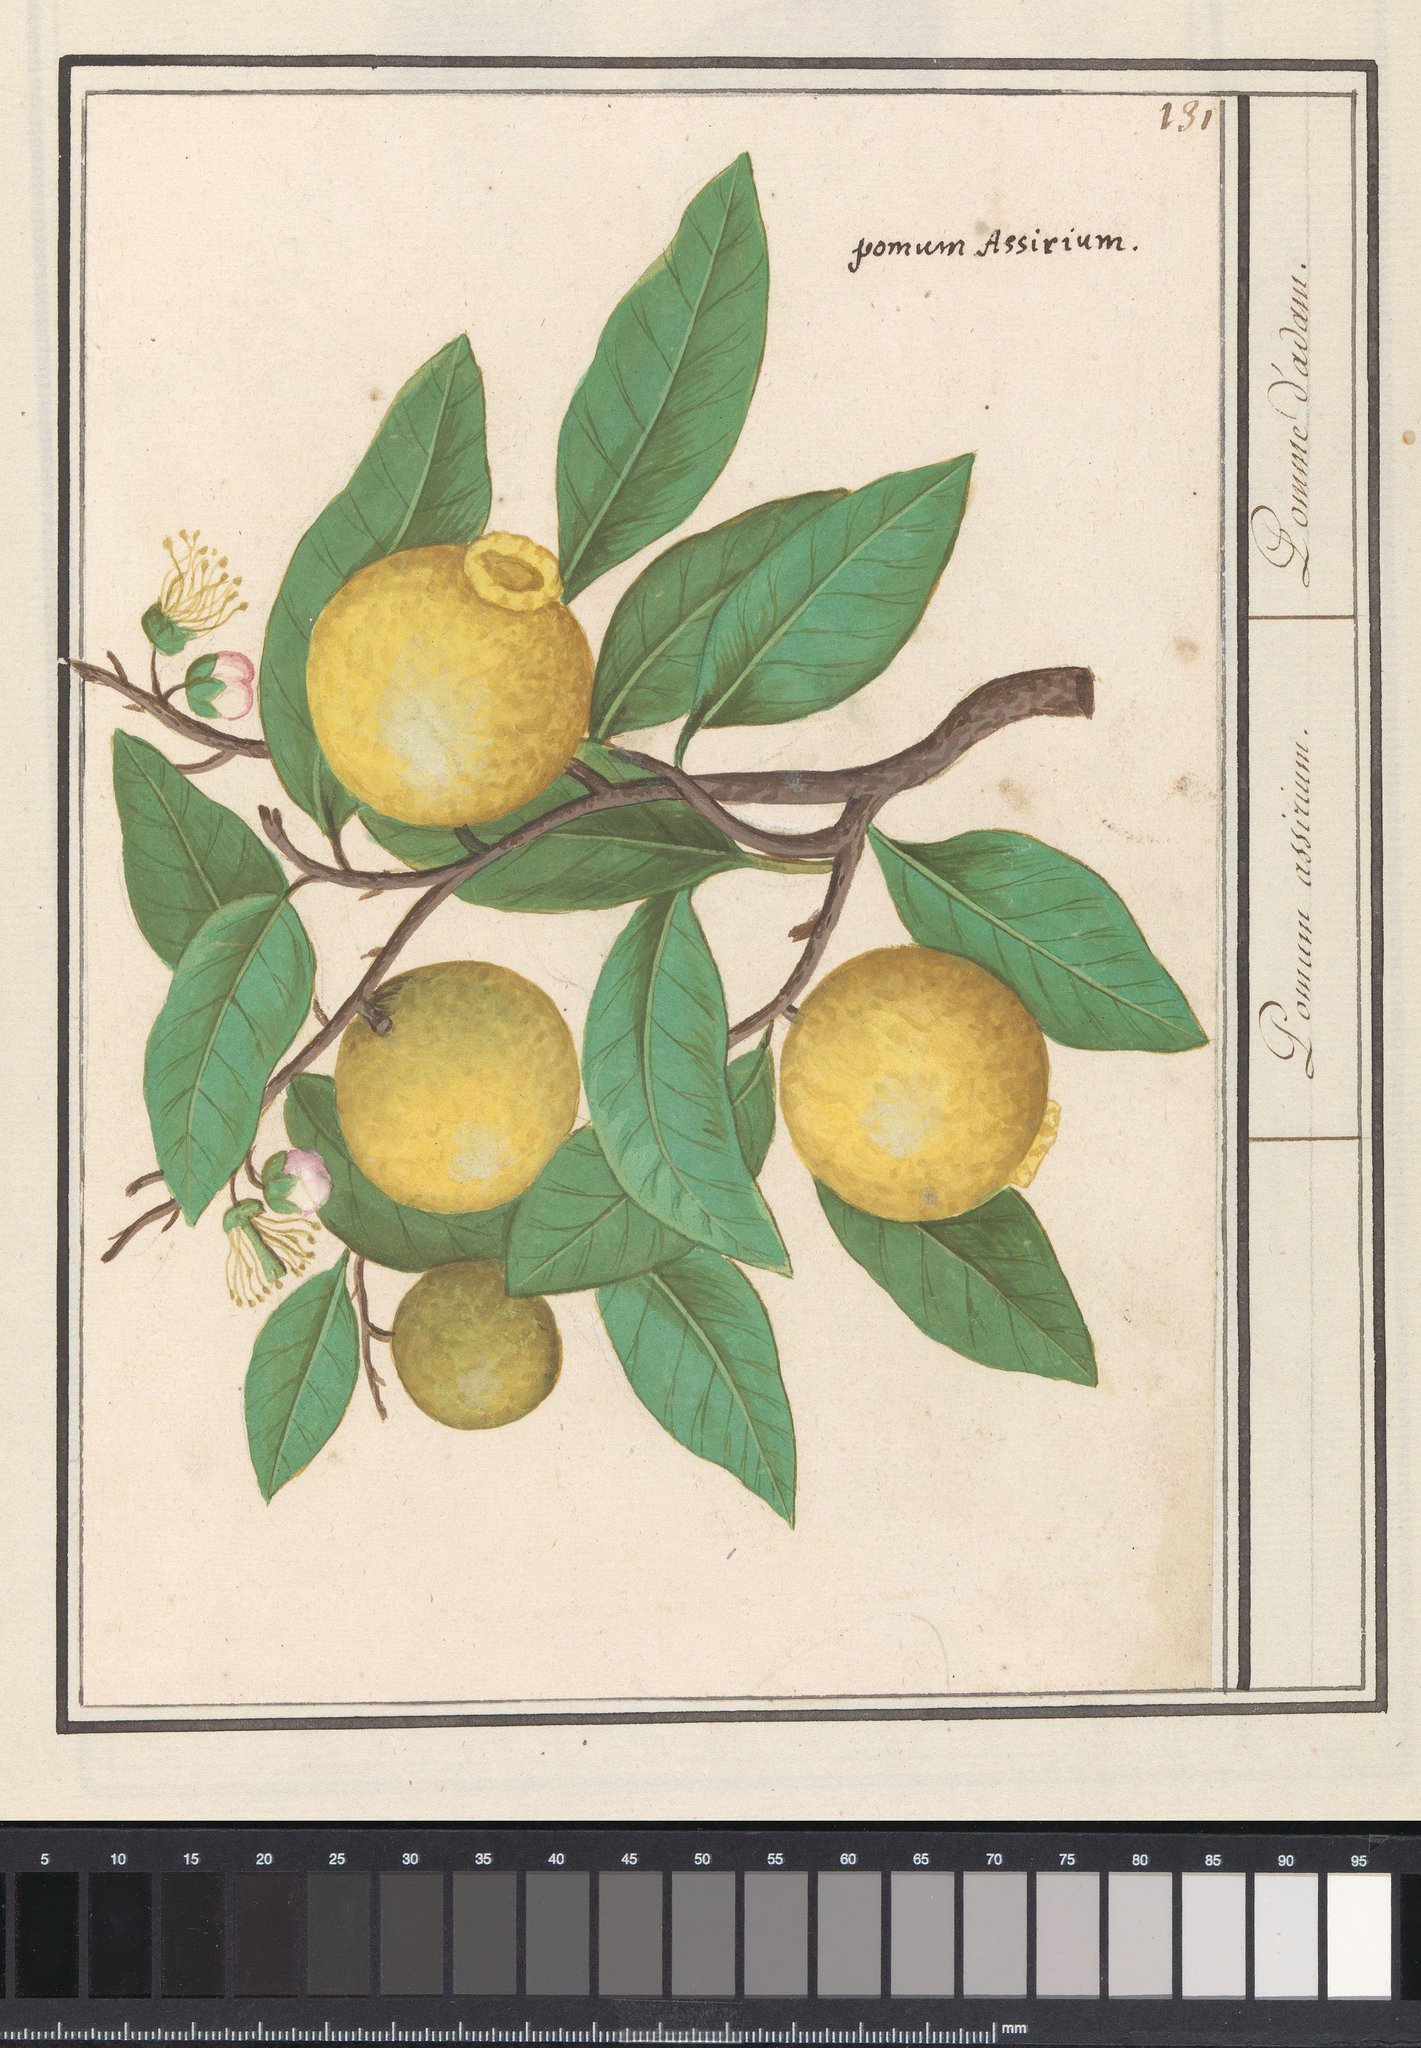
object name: drawing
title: Lemon (Citrus limon)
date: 1596-1610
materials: chalk, paint, ink, paper, watercolor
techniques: brush, pen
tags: fruits: lemon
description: The lemon tree is native to Southeast Asia and was brought to Europe by traders. It was planted in the Royal Gardens in Prague at the beginning of the 16th century, marking the onset of a veritable lemon craze at the imperial court. Orangeries were built to protect the precious plant and fruit from the harsh European winter.